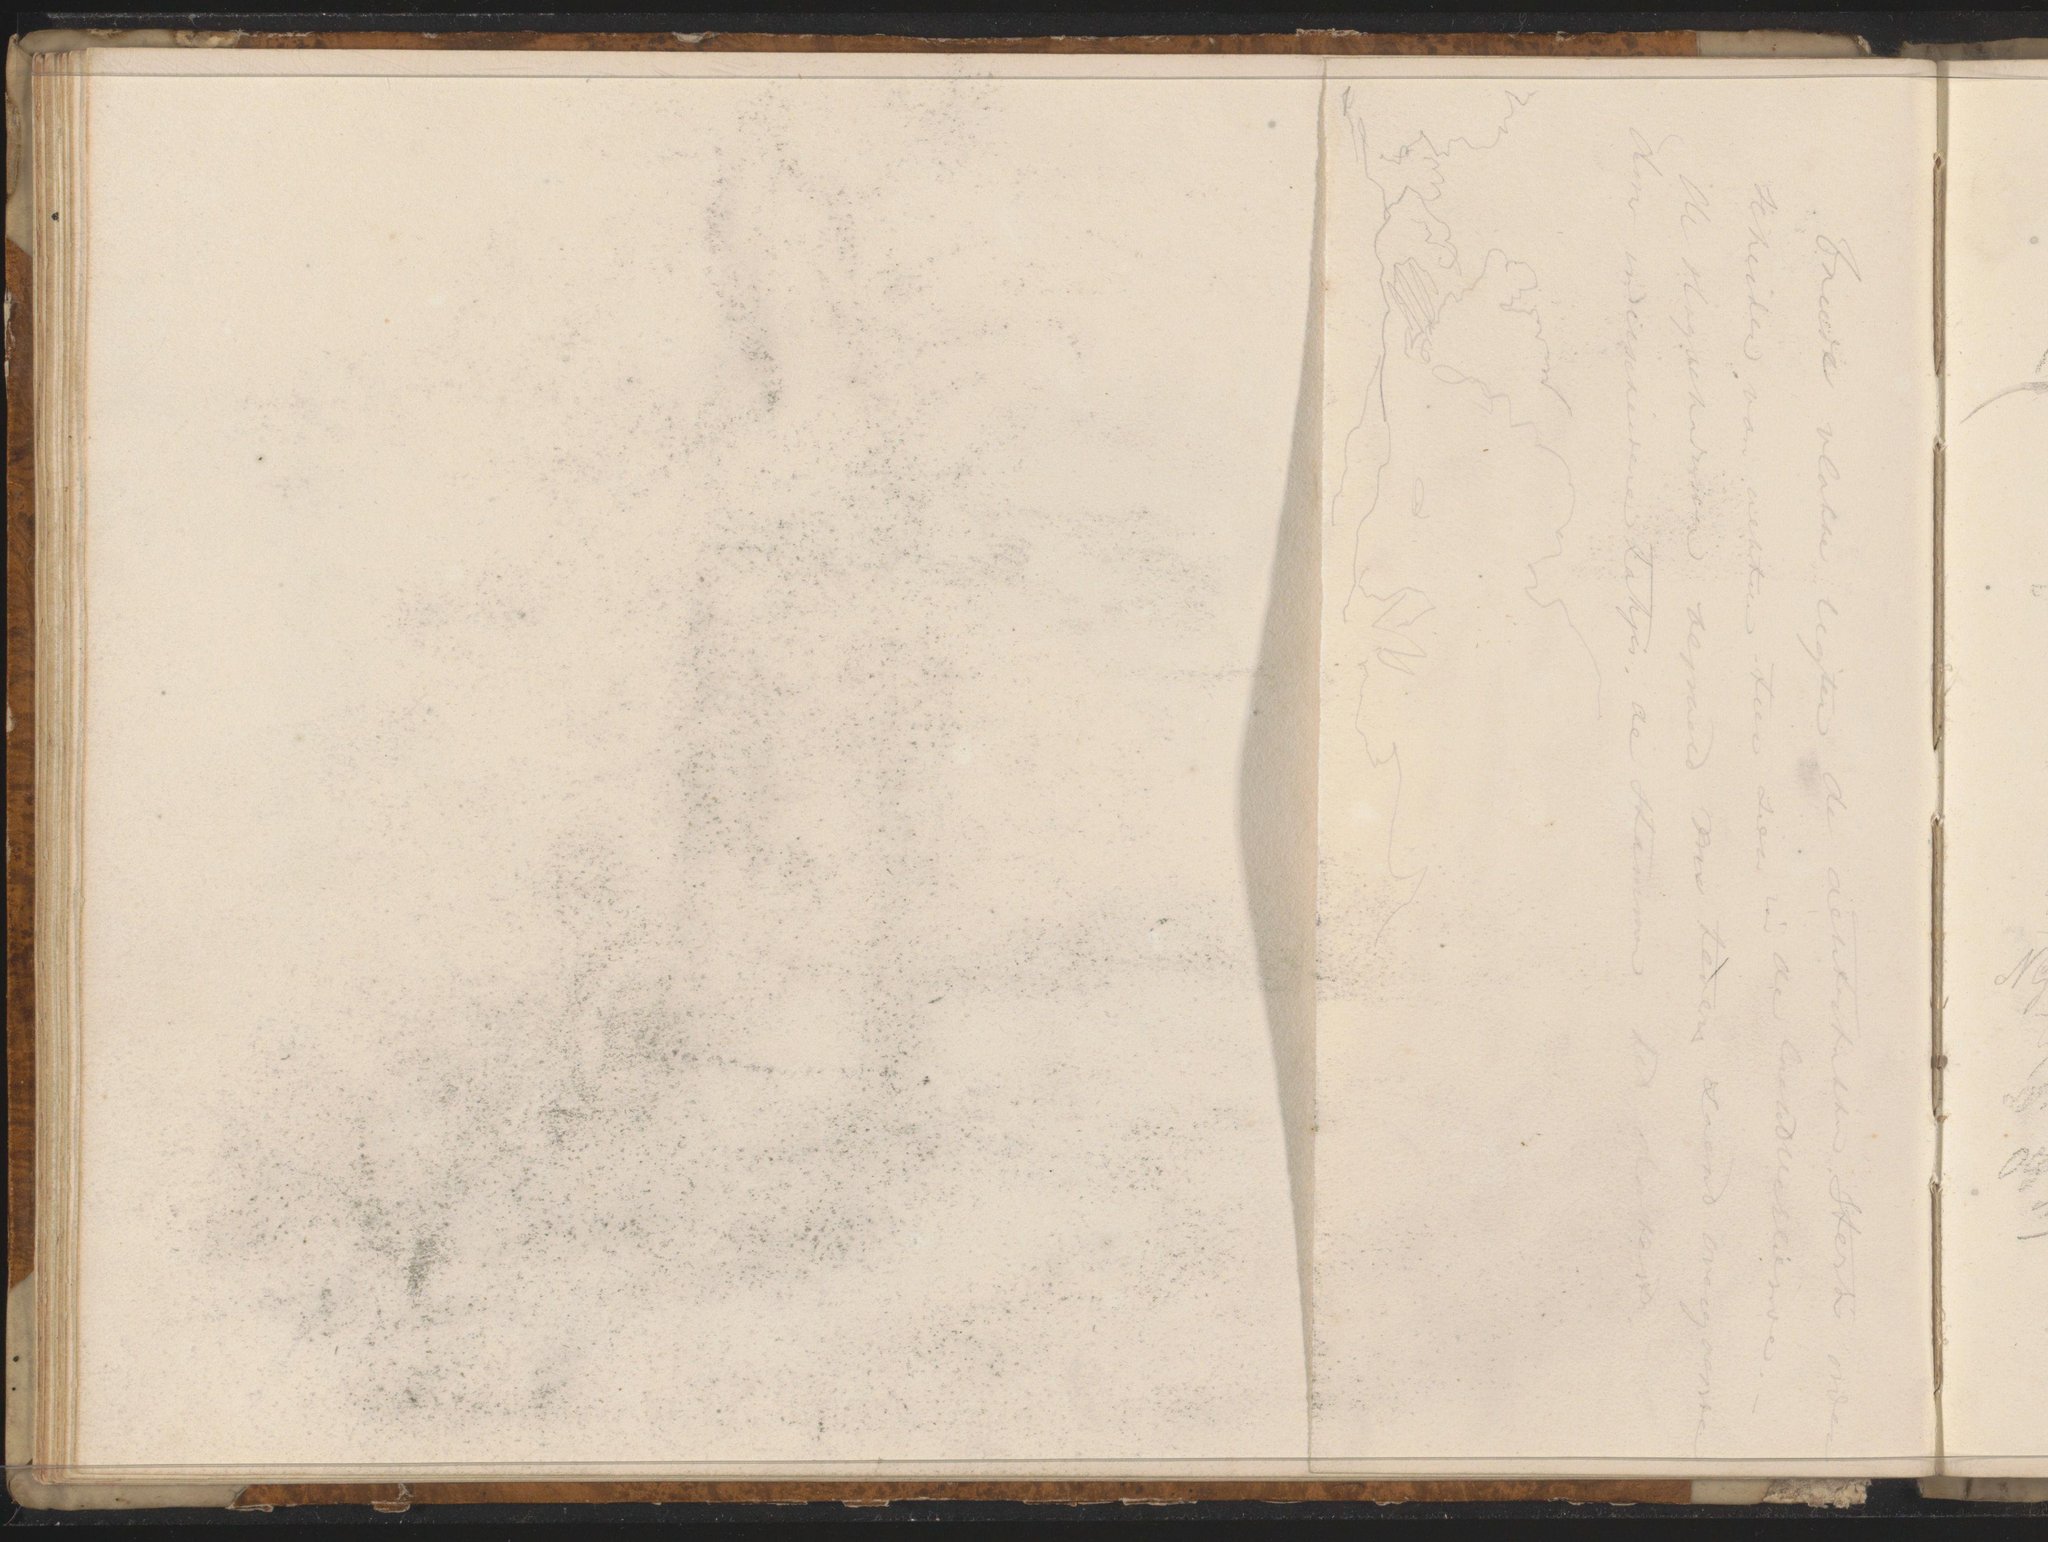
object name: sketchbook leaf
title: Wolken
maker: maria vos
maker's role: draughtsman, painter, print maker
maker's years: 1824-1906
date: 1834-1906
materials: paper, pencil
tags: clouds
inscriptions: kleurnotitie, handgeschreven in potlood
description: De pagina is grotendeels uit het schetsboek gescheurd.